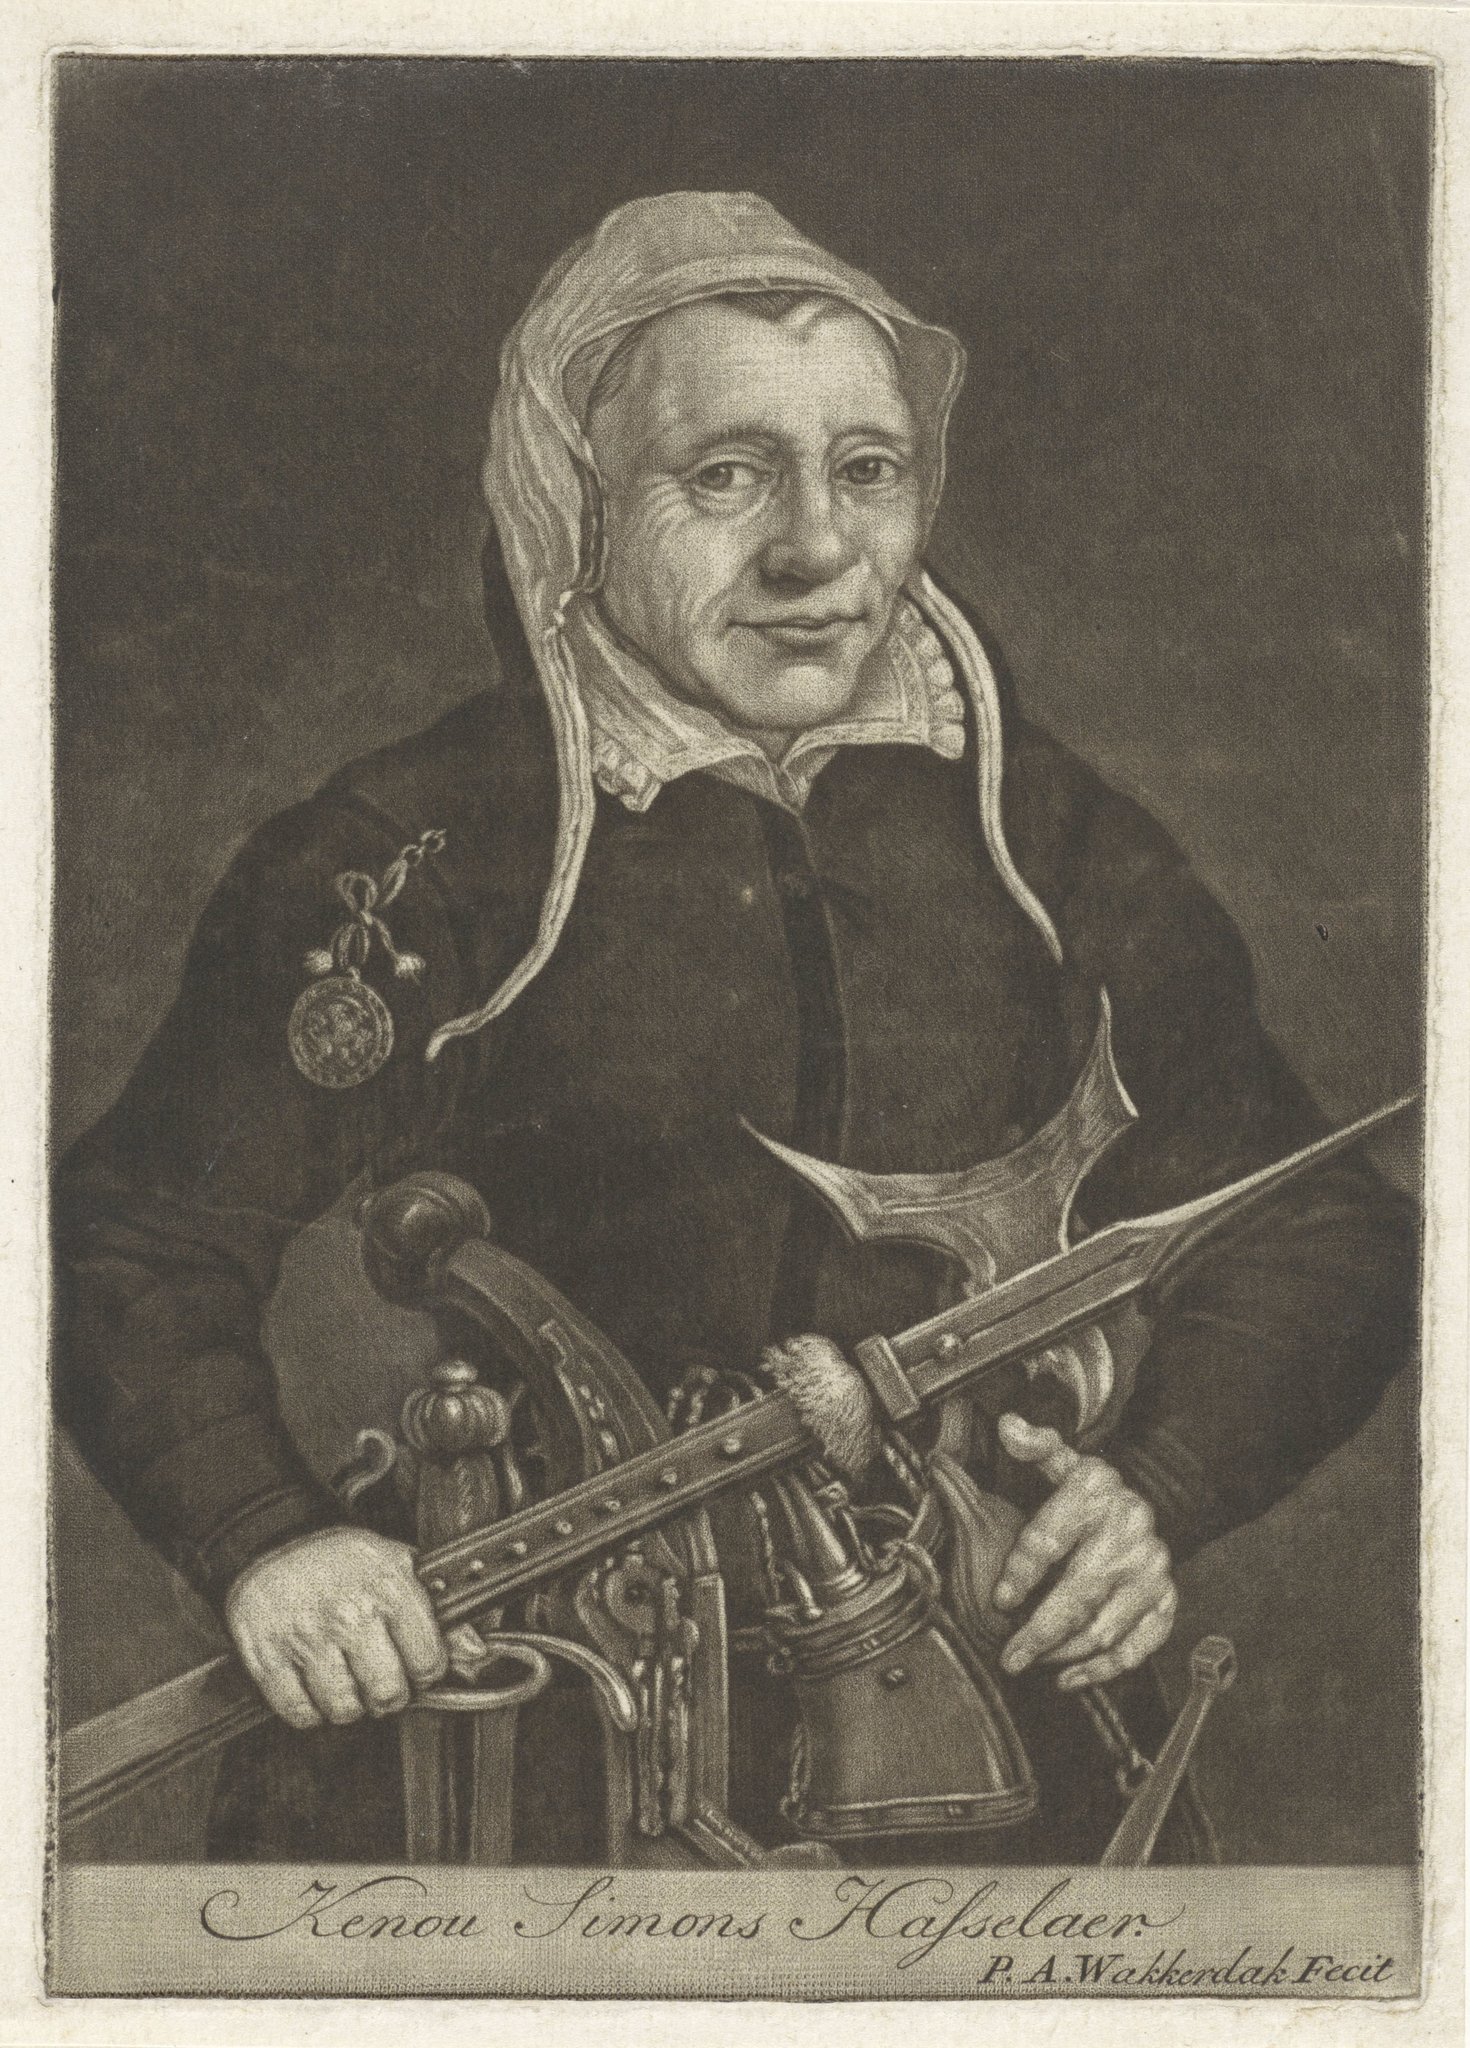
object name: print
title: Portret van Kenau Simonsdochter Hasselaer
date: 1740-1774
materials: paper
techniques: mezzotint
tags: weapons, haarlem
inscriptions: collector's mark: Lugt 2228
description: Kenau Simonsdochter Hasselaer is bewapend en heeft op haar rechterarm een medaillon met de Hollandse Leeuw.